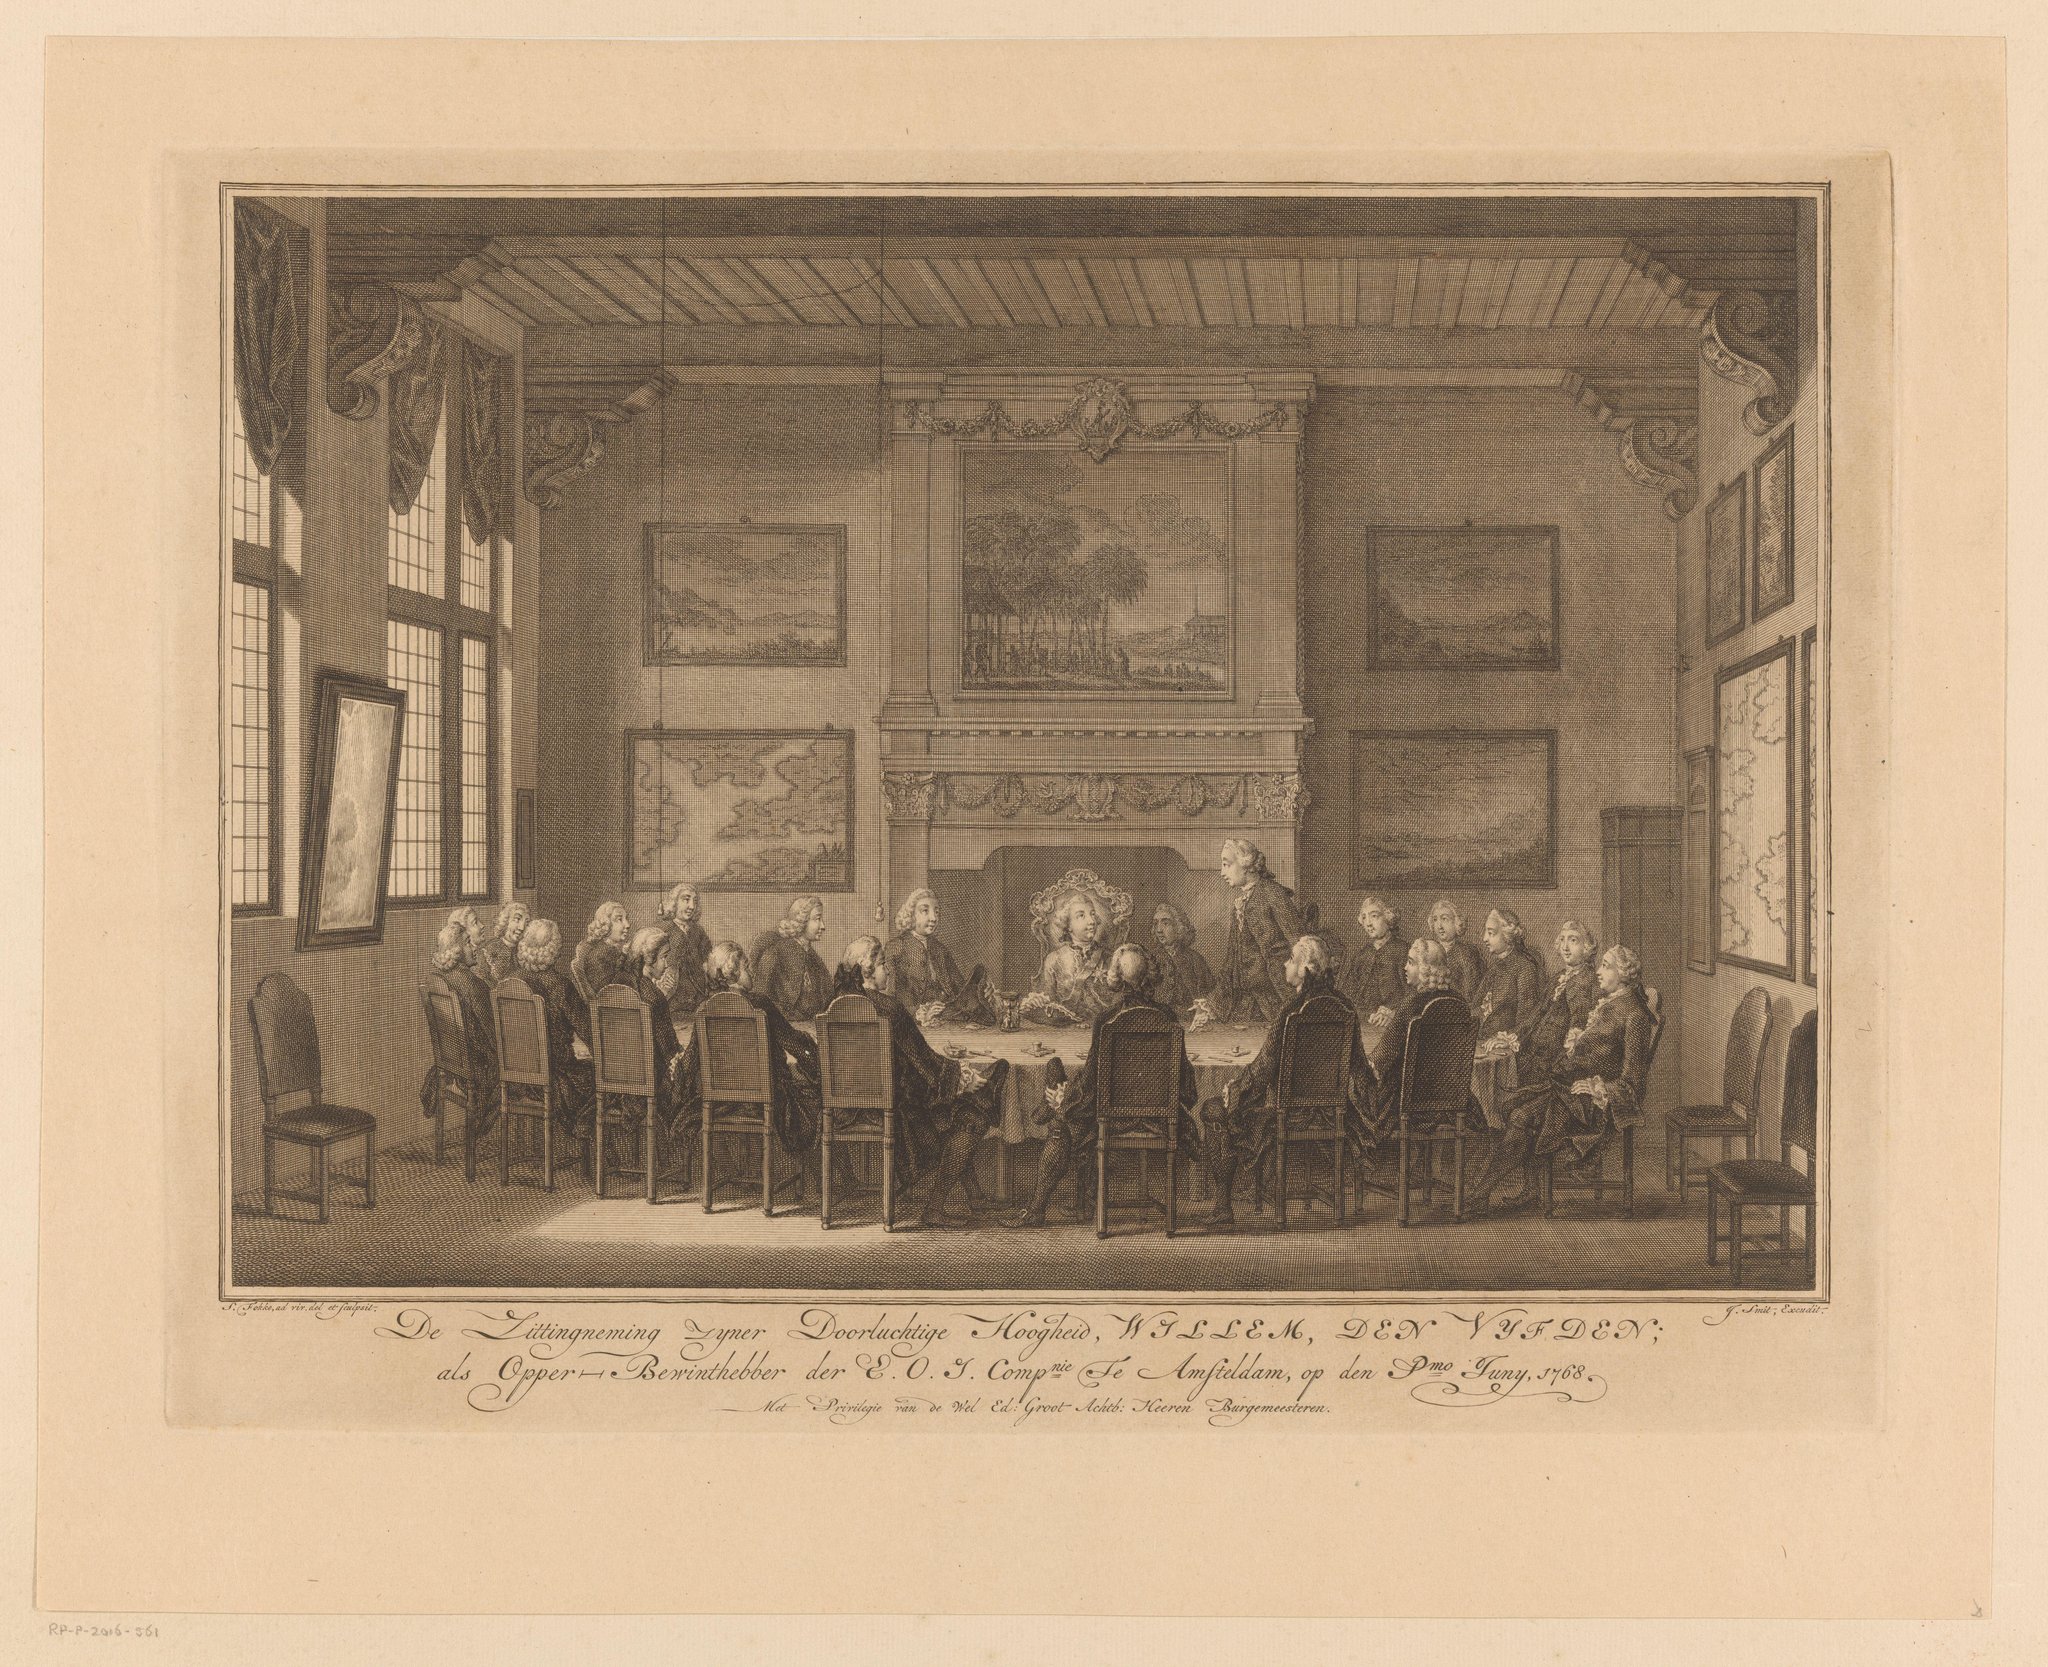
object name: print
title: Afbeelding der vreugdebedryven en plegtigheden die by de aankomst en gedurende het verblyf hunner (...) Willem, Prince van Oranje en Nassau, (...) en zyne gemaalinne Fredrica Sophia Wilhelmina, Princesse van Pruissen, zyn voorgevallen te Amsterdam, op maandag, den 30 mey, en eenige volgende dagen, des jaars 1768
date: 1772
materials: paper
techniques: engraving, etching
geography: amsterdam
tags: the hague, william v (prince of orange), draughtsman, wilhelmina of prussia (princess of orange), meeting, assembly, amsterdam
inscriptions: collector's mark: Lugt 2228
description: Stadhouder Willem V neemt als opperbewindhebber zitting tussen de directeuren van de VOC te Amsterdam, 1 juni 1768.